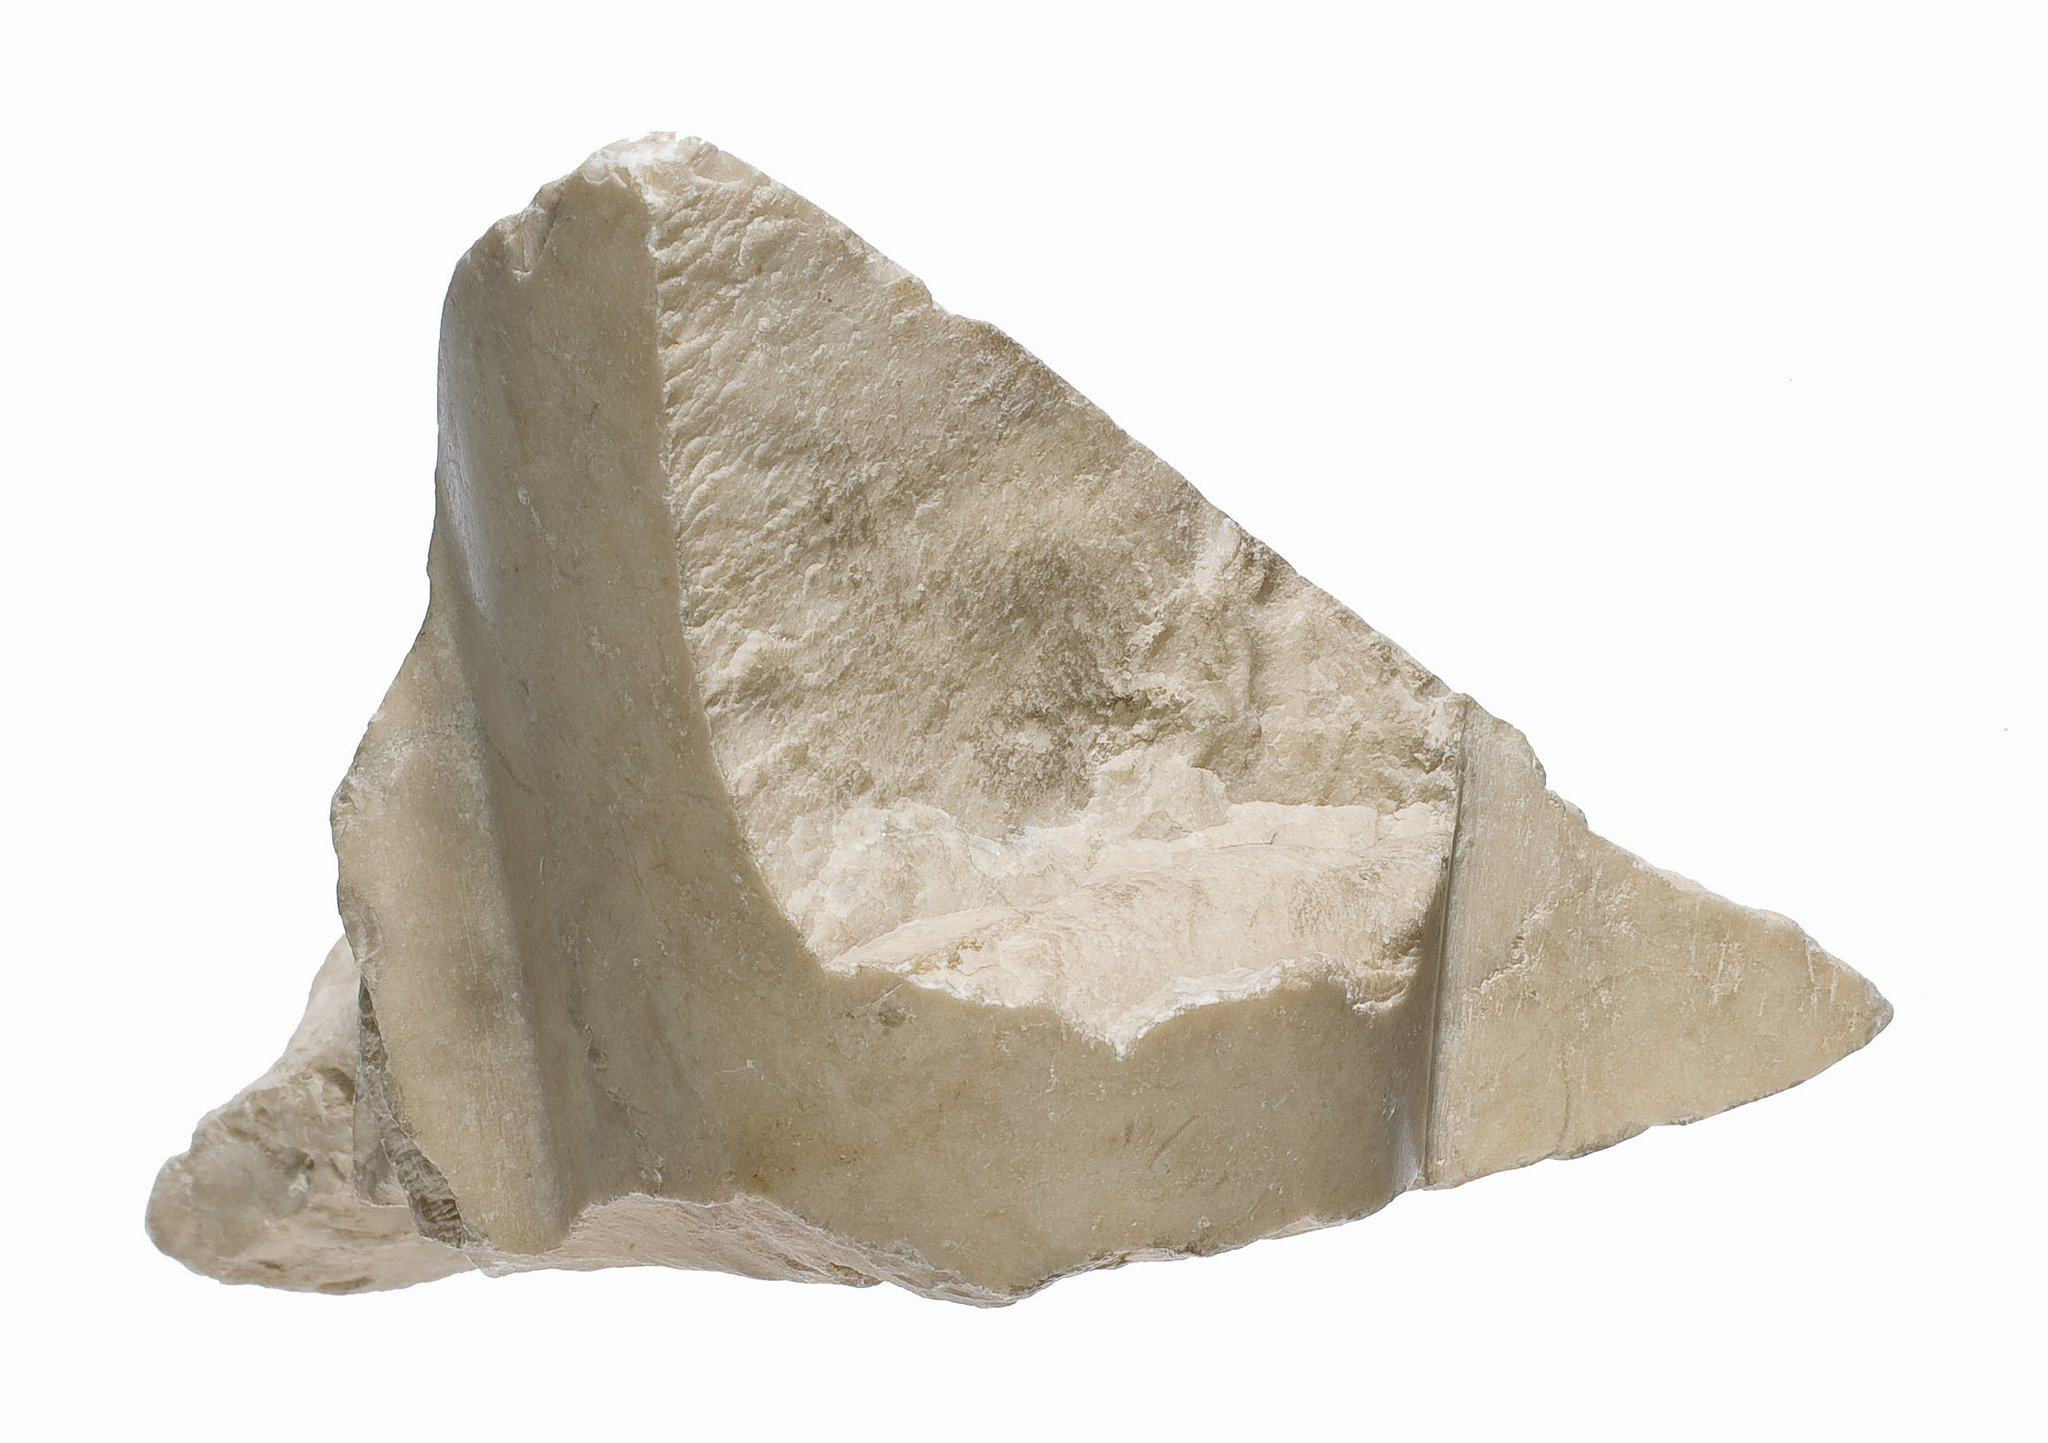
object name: offering table with arm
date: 1353-1336 BCE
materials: limestone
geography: egypt